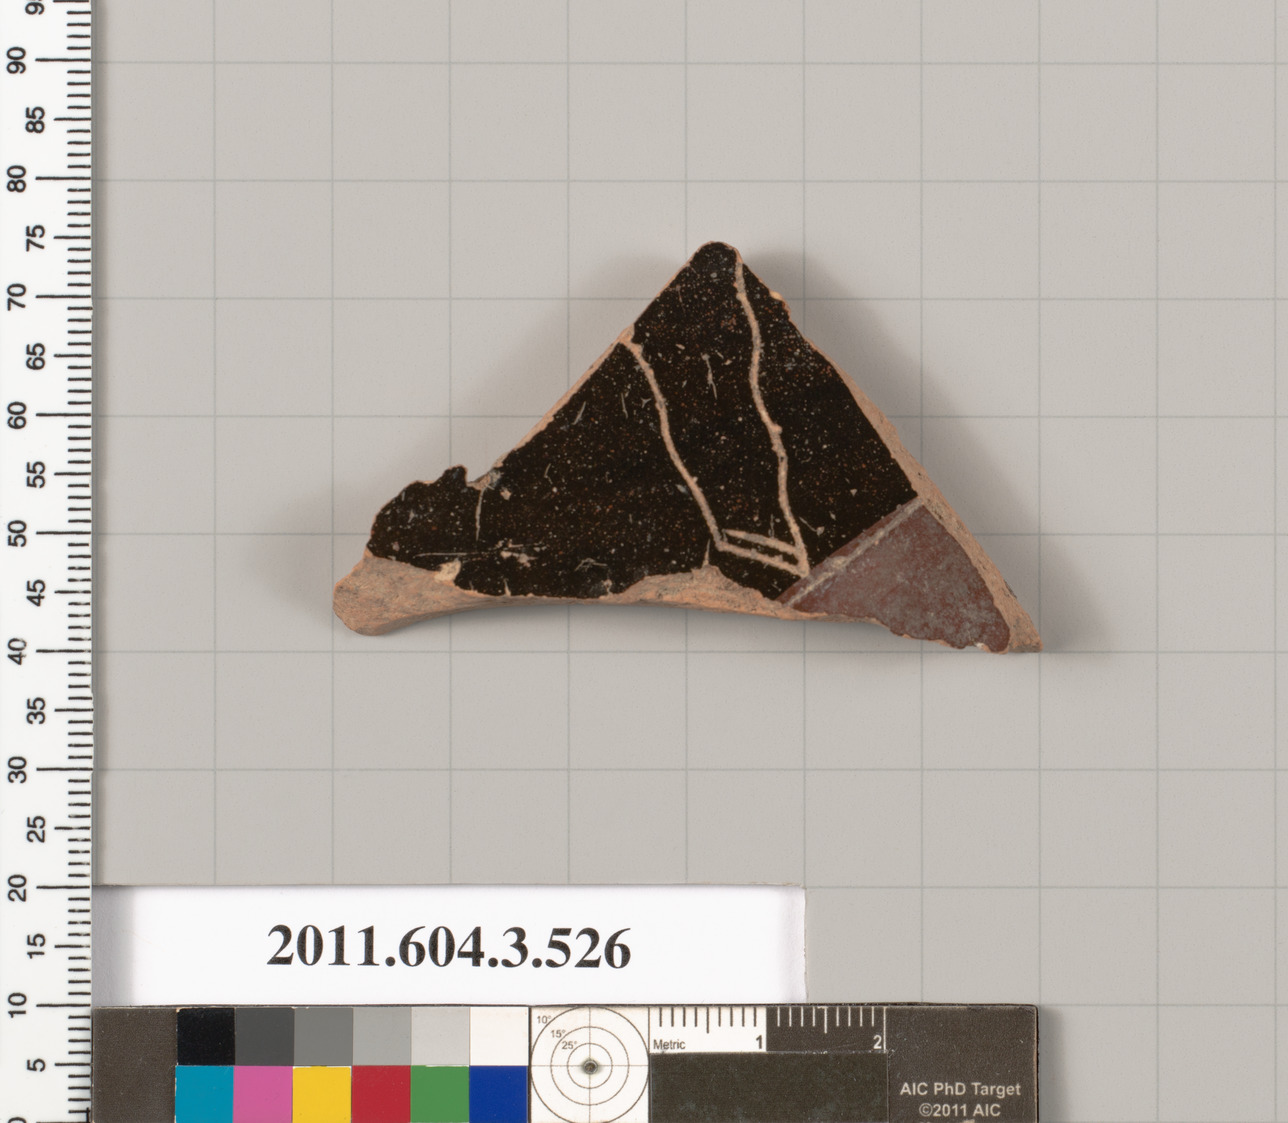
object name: column krater fragment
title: Terracotta fragment of a column-krater (bowl for mixing wine and water)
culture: greek, attic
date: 510-500 BCE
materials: terracotta